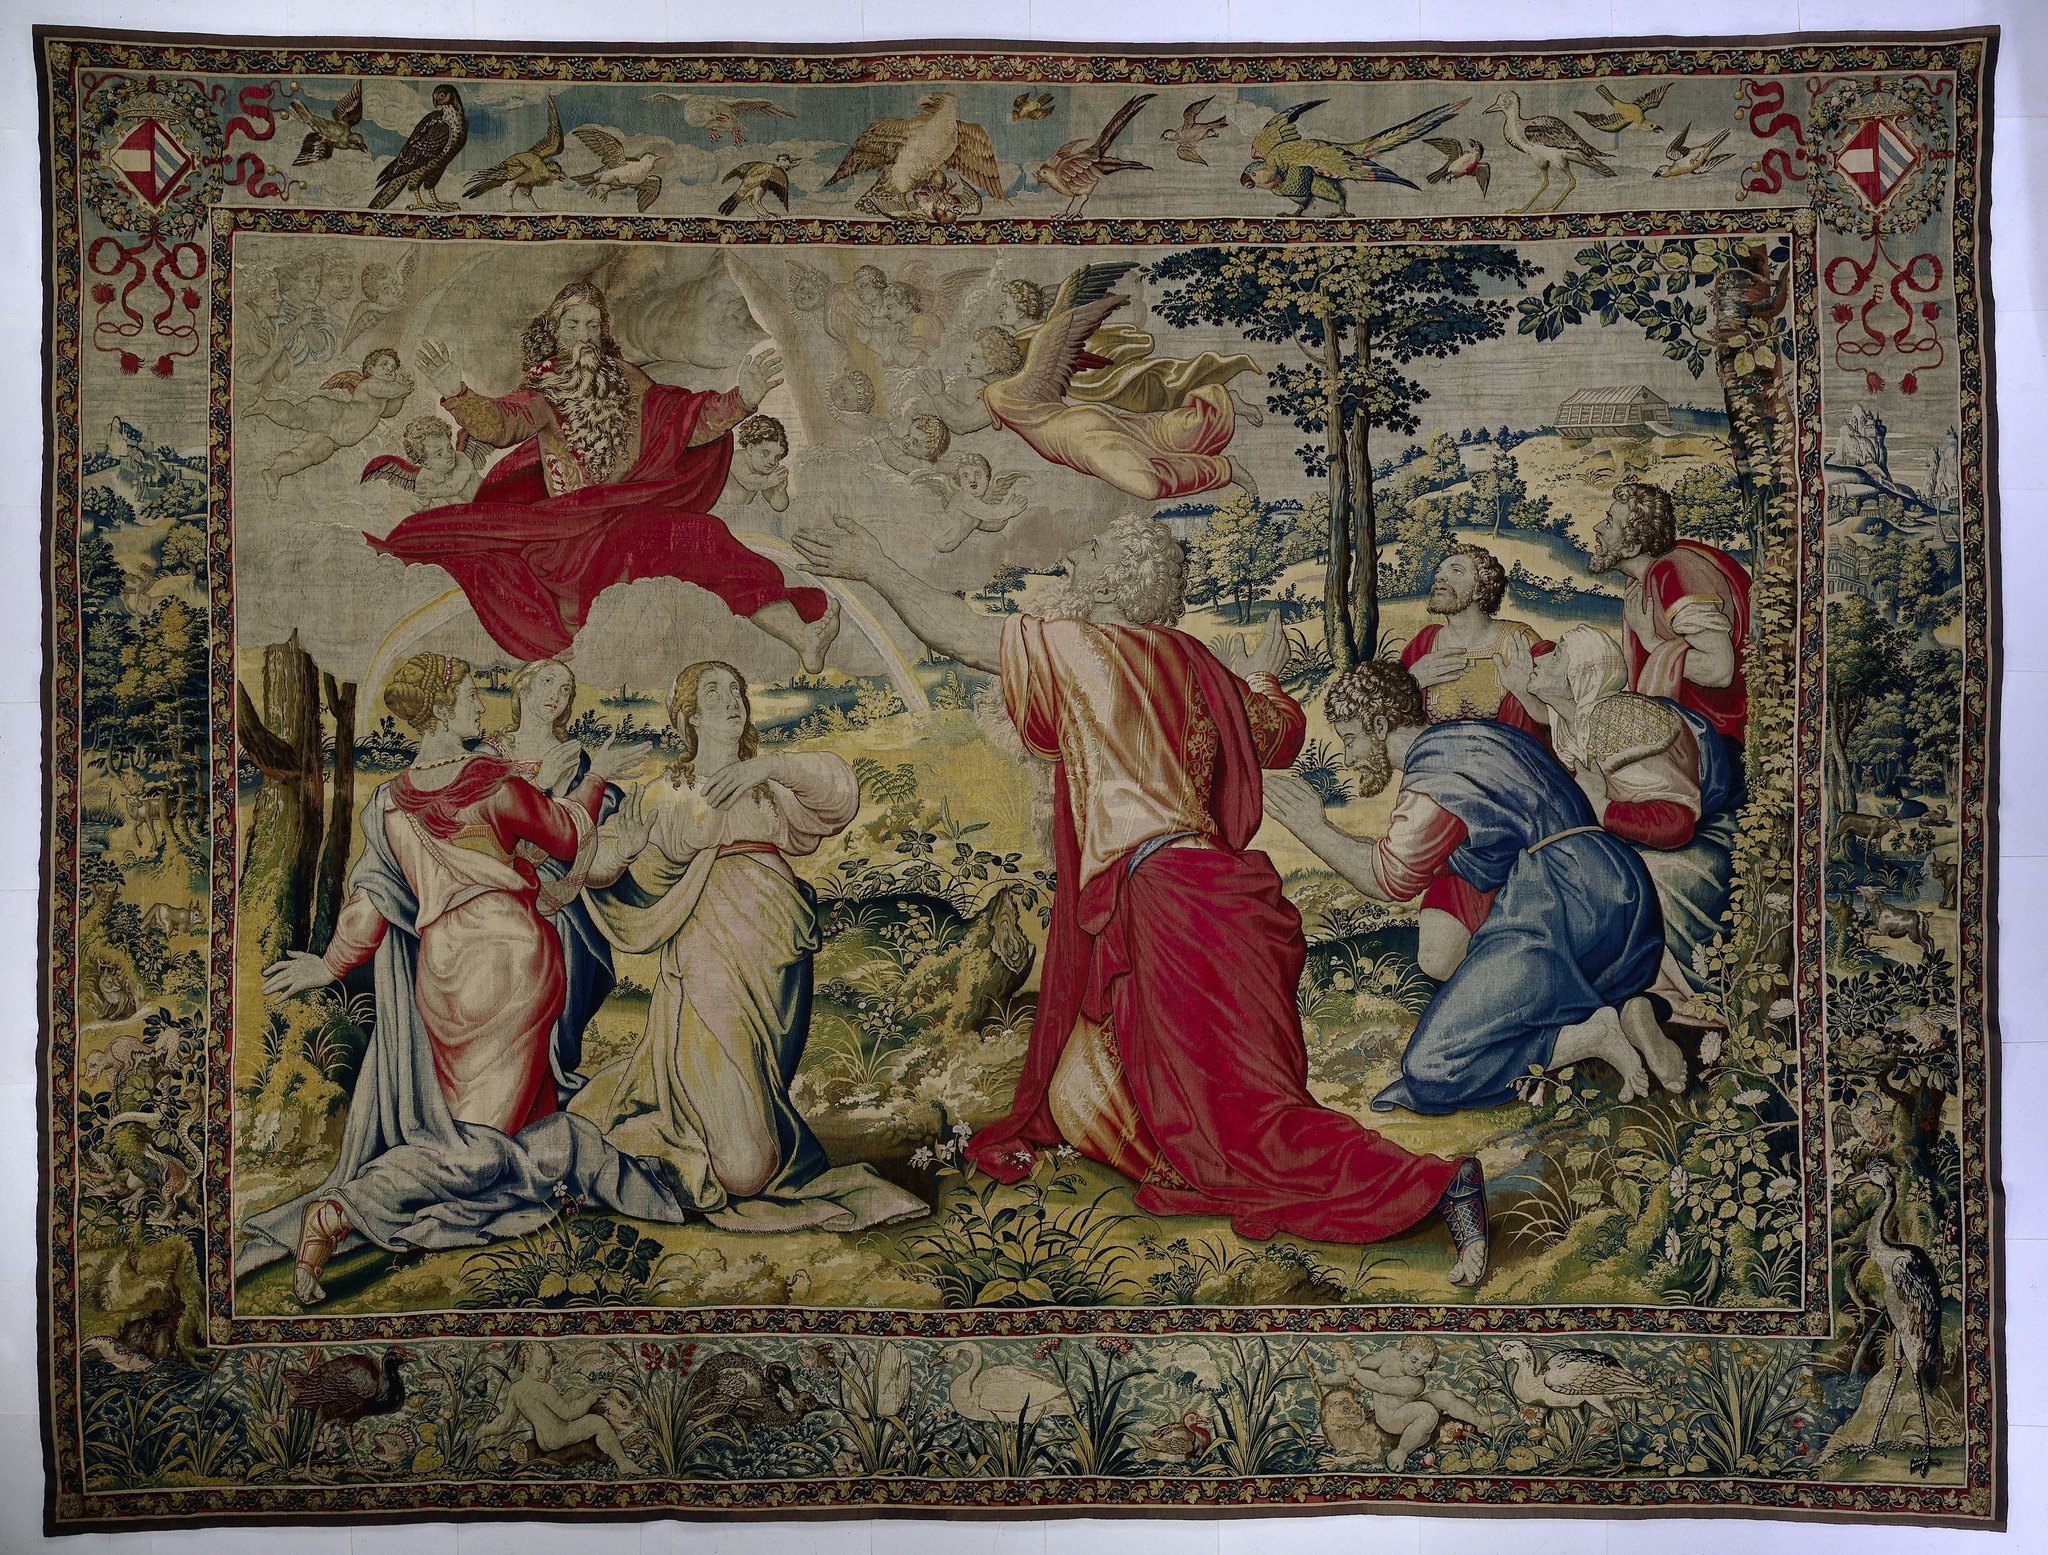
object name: tapestry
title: God Blesses Noah's Family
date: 1567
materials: silk, wool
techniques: tapestry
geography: brussels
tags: animals, god's covenant with noah: never again shall there be a flood; as a sign of this covenant god puts a rainbow in the sky, god blesses noah and gives him his commandments, birds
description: Tapestry with the Covenant of God and Noah. With the arms of Margaret of Parma, regent of the Netherlands. From a series with the history of Noah. Wool and silk. Brussels, ca. 1565, by Willem de Pannemaker, the design attributed to Michiel Coxcie. Gift of the Committee for Photographic Sales, 1955.